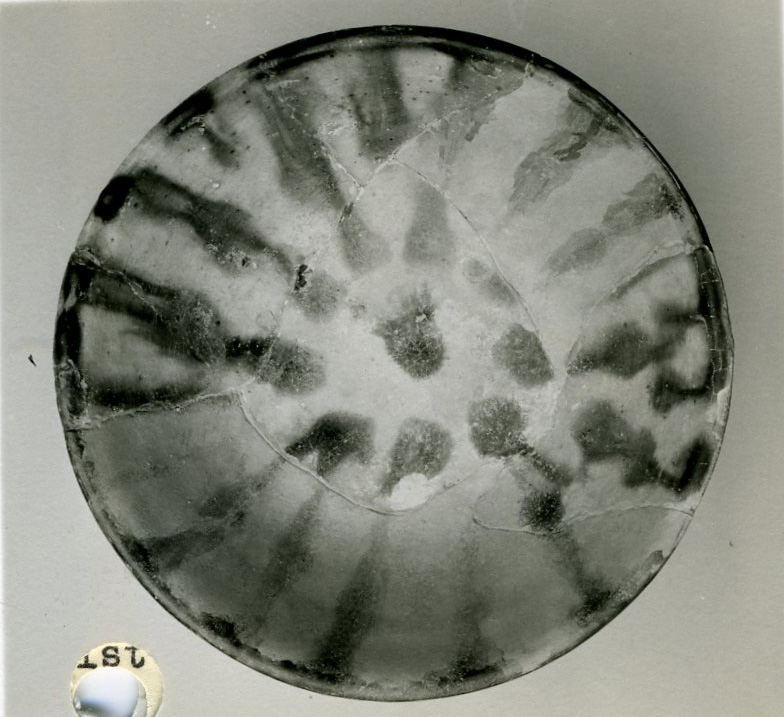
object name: bowl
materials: earthenware, glaze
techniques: polychrome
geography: iran